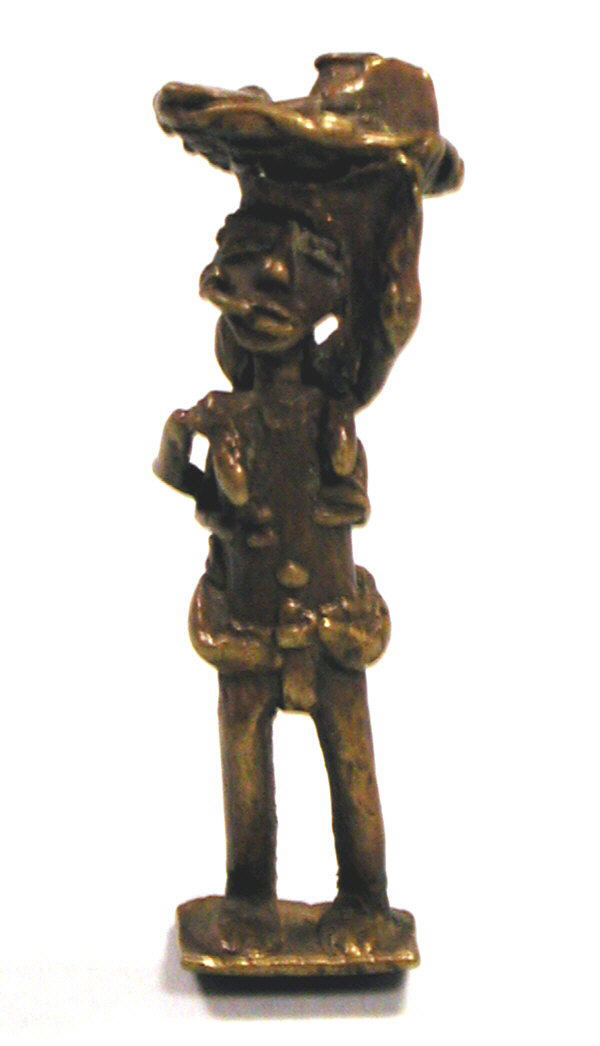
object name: weight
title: Gold Weight: Mother and Child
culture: akan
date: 1701-1900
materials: brass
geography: ghana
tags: infants,mothers